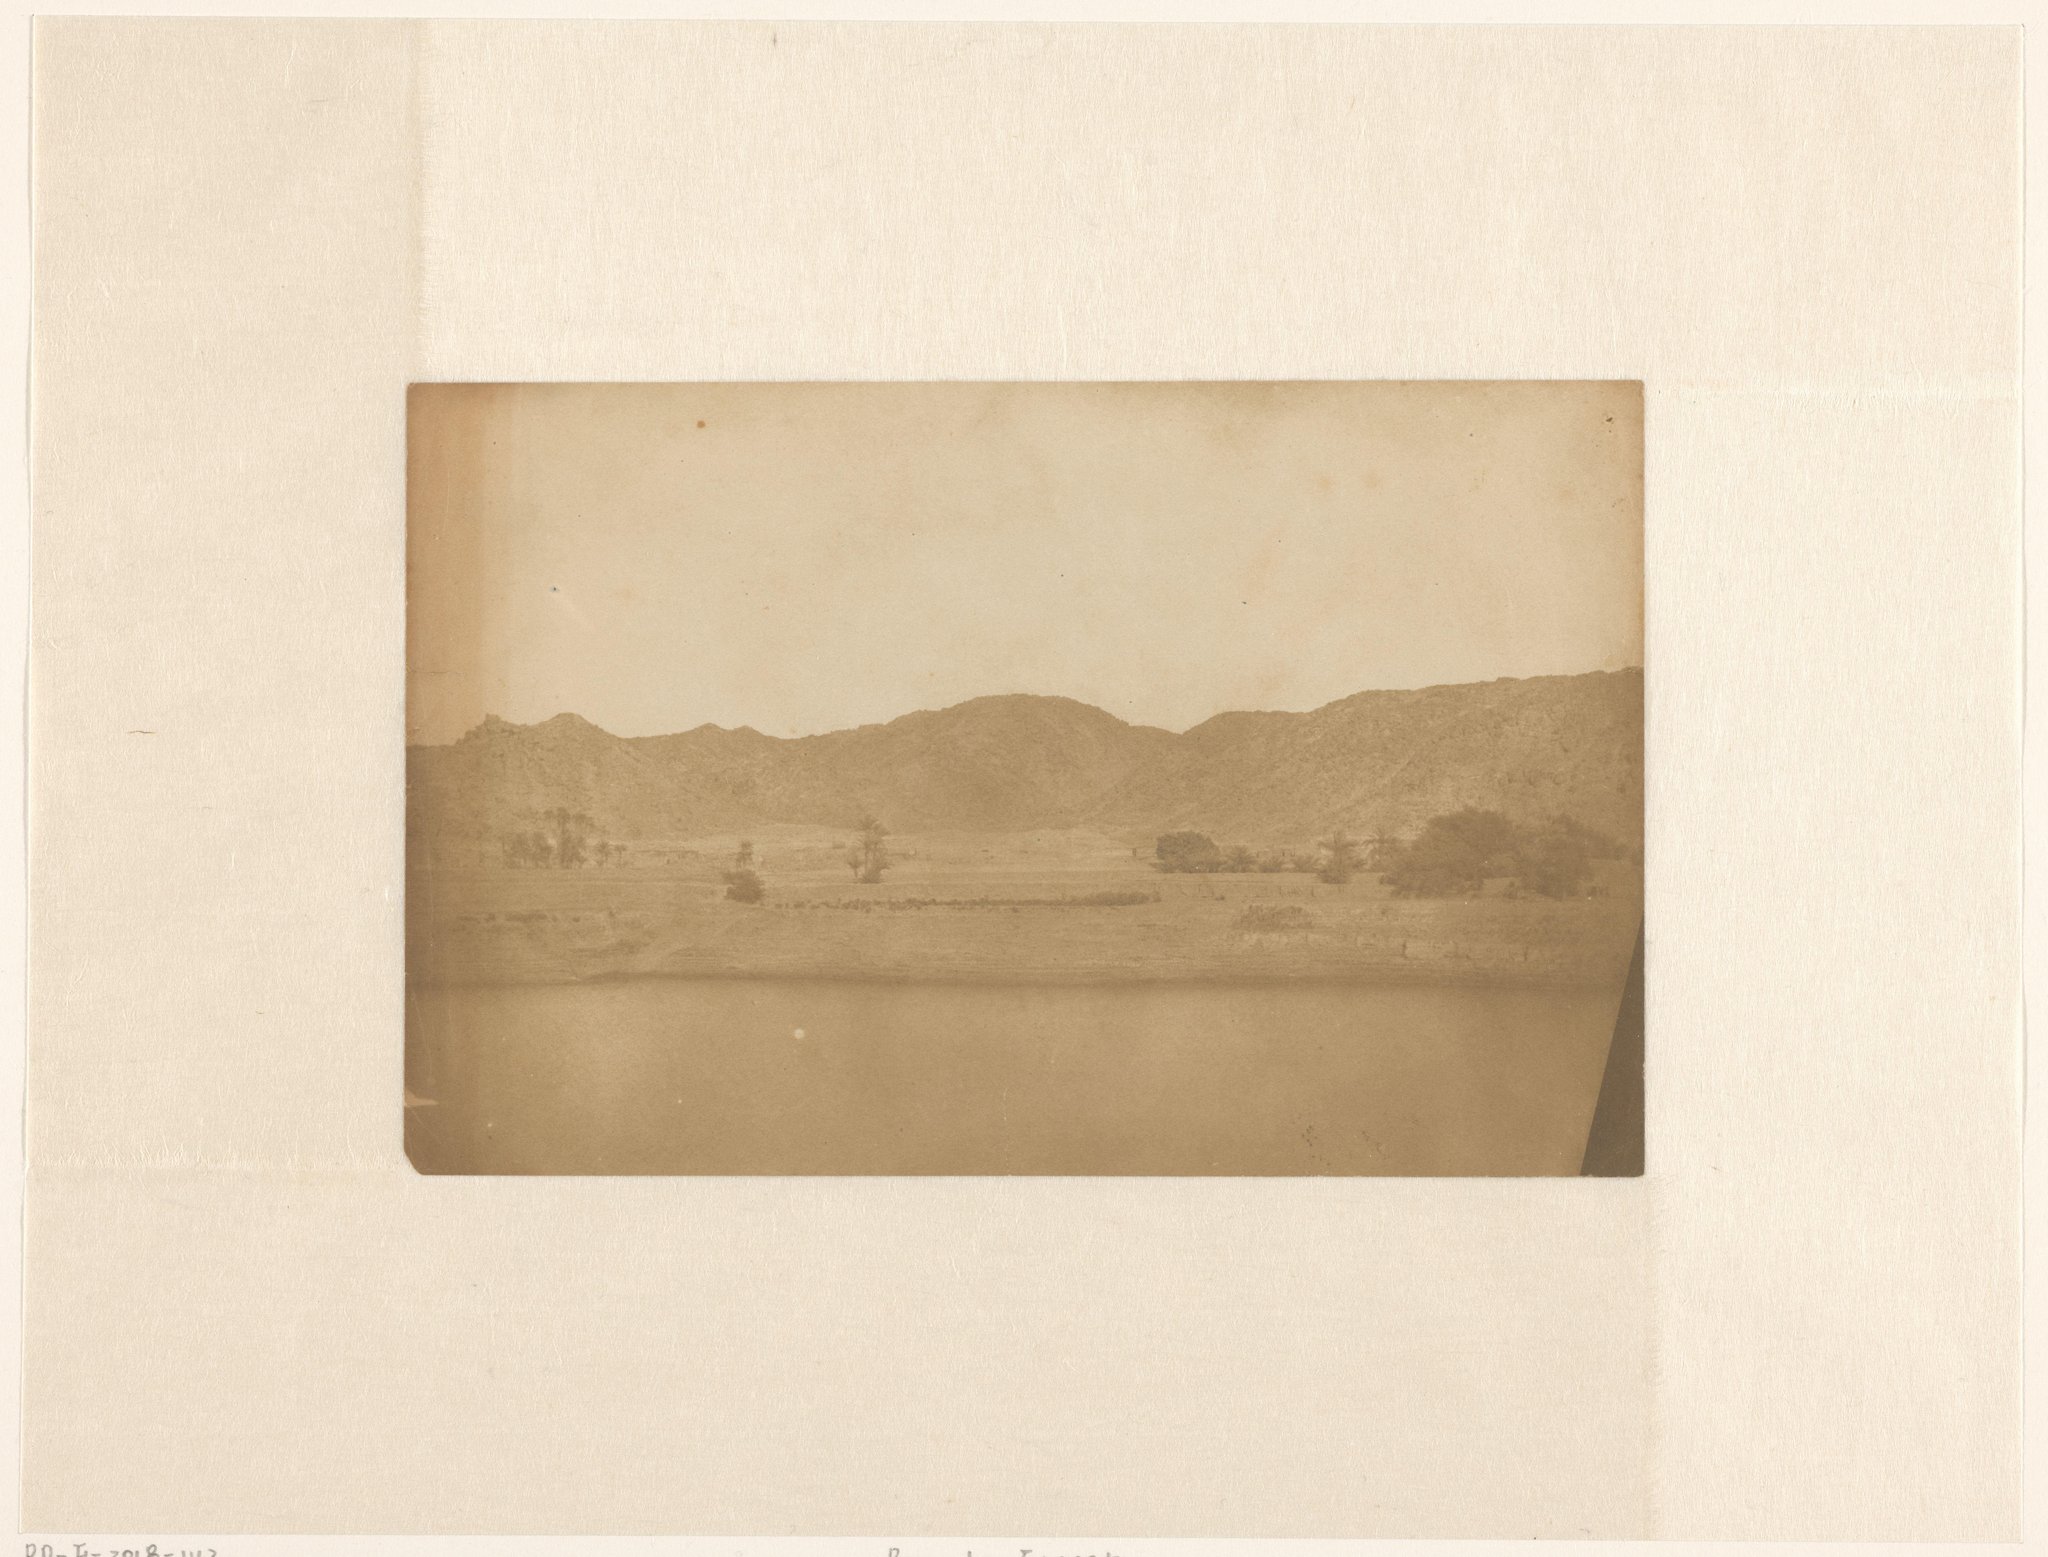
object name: photograph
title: En Nubie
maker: ernest benecke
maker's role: fotograaf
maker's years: 1828-1884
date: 1852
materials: photographic support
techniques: salted paper print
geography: nubia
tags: low hill country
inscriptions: inscription: ‘En Nubie’, inscription: ‘1082/7’